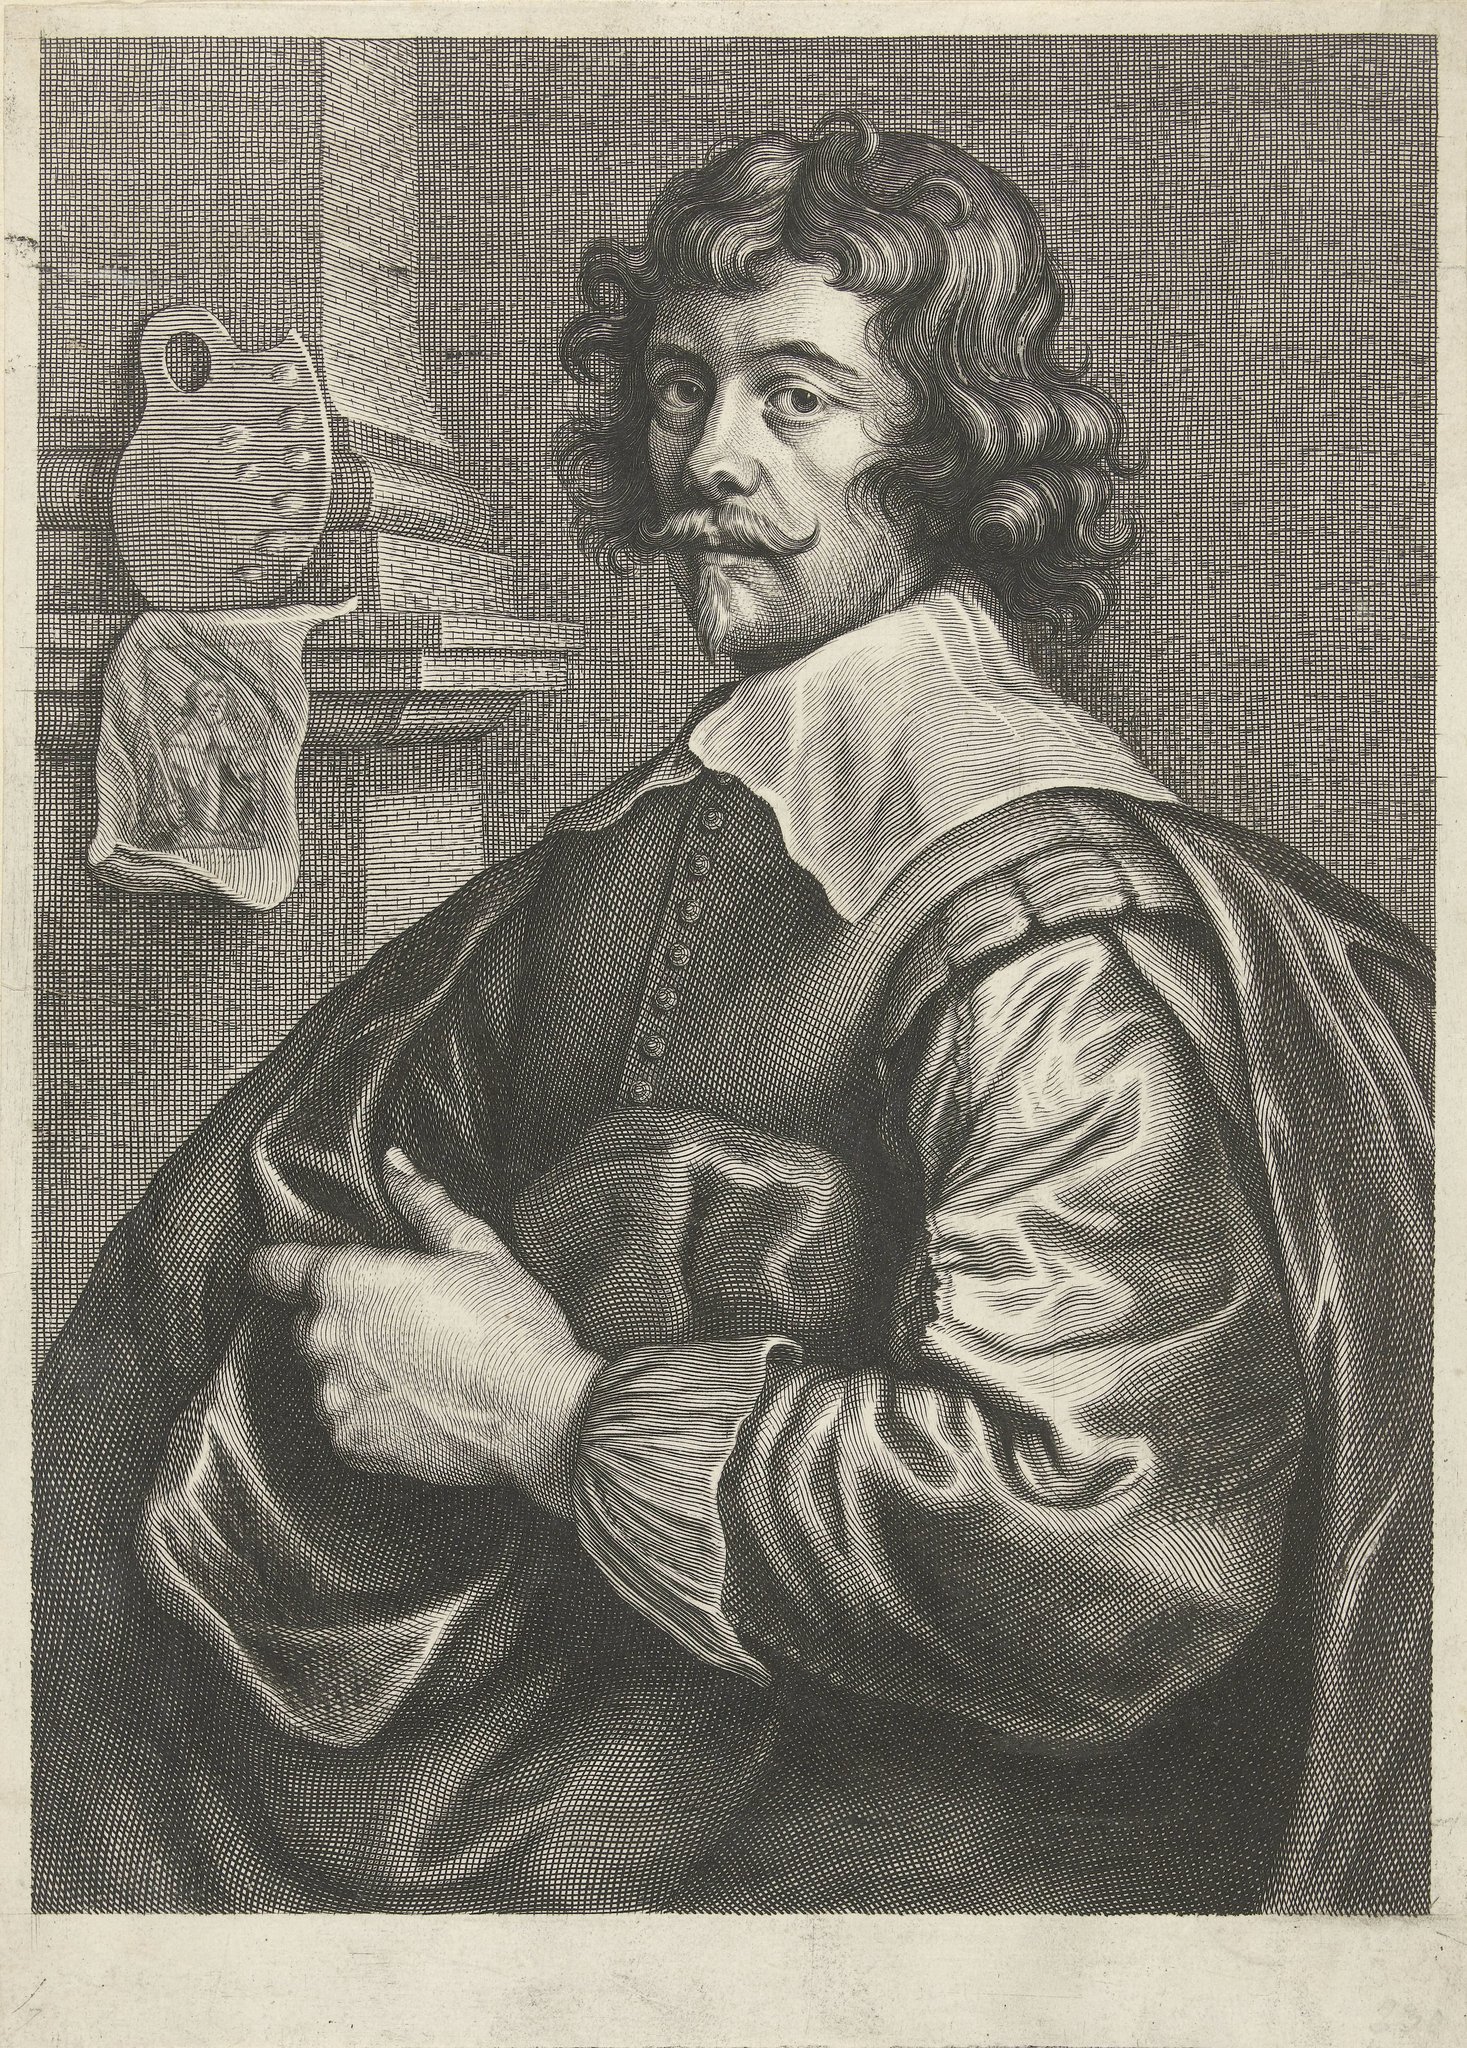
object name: print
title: Portret van Joannes Meyssens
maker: cornelis galle (ii)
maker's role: print maker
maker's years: 1615-1678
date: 1638-1650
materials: paper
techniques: engraving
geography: antwerp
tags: brussels, antwerp, print maker, joannes meyssens, portrait, self-portrait of artist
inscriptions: collector's mark: Lugt 240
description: Portret van de kunstenaar en uitgever Joannes Meyssens. Op de achtergrond een basement met erop een portretprent en een palet.